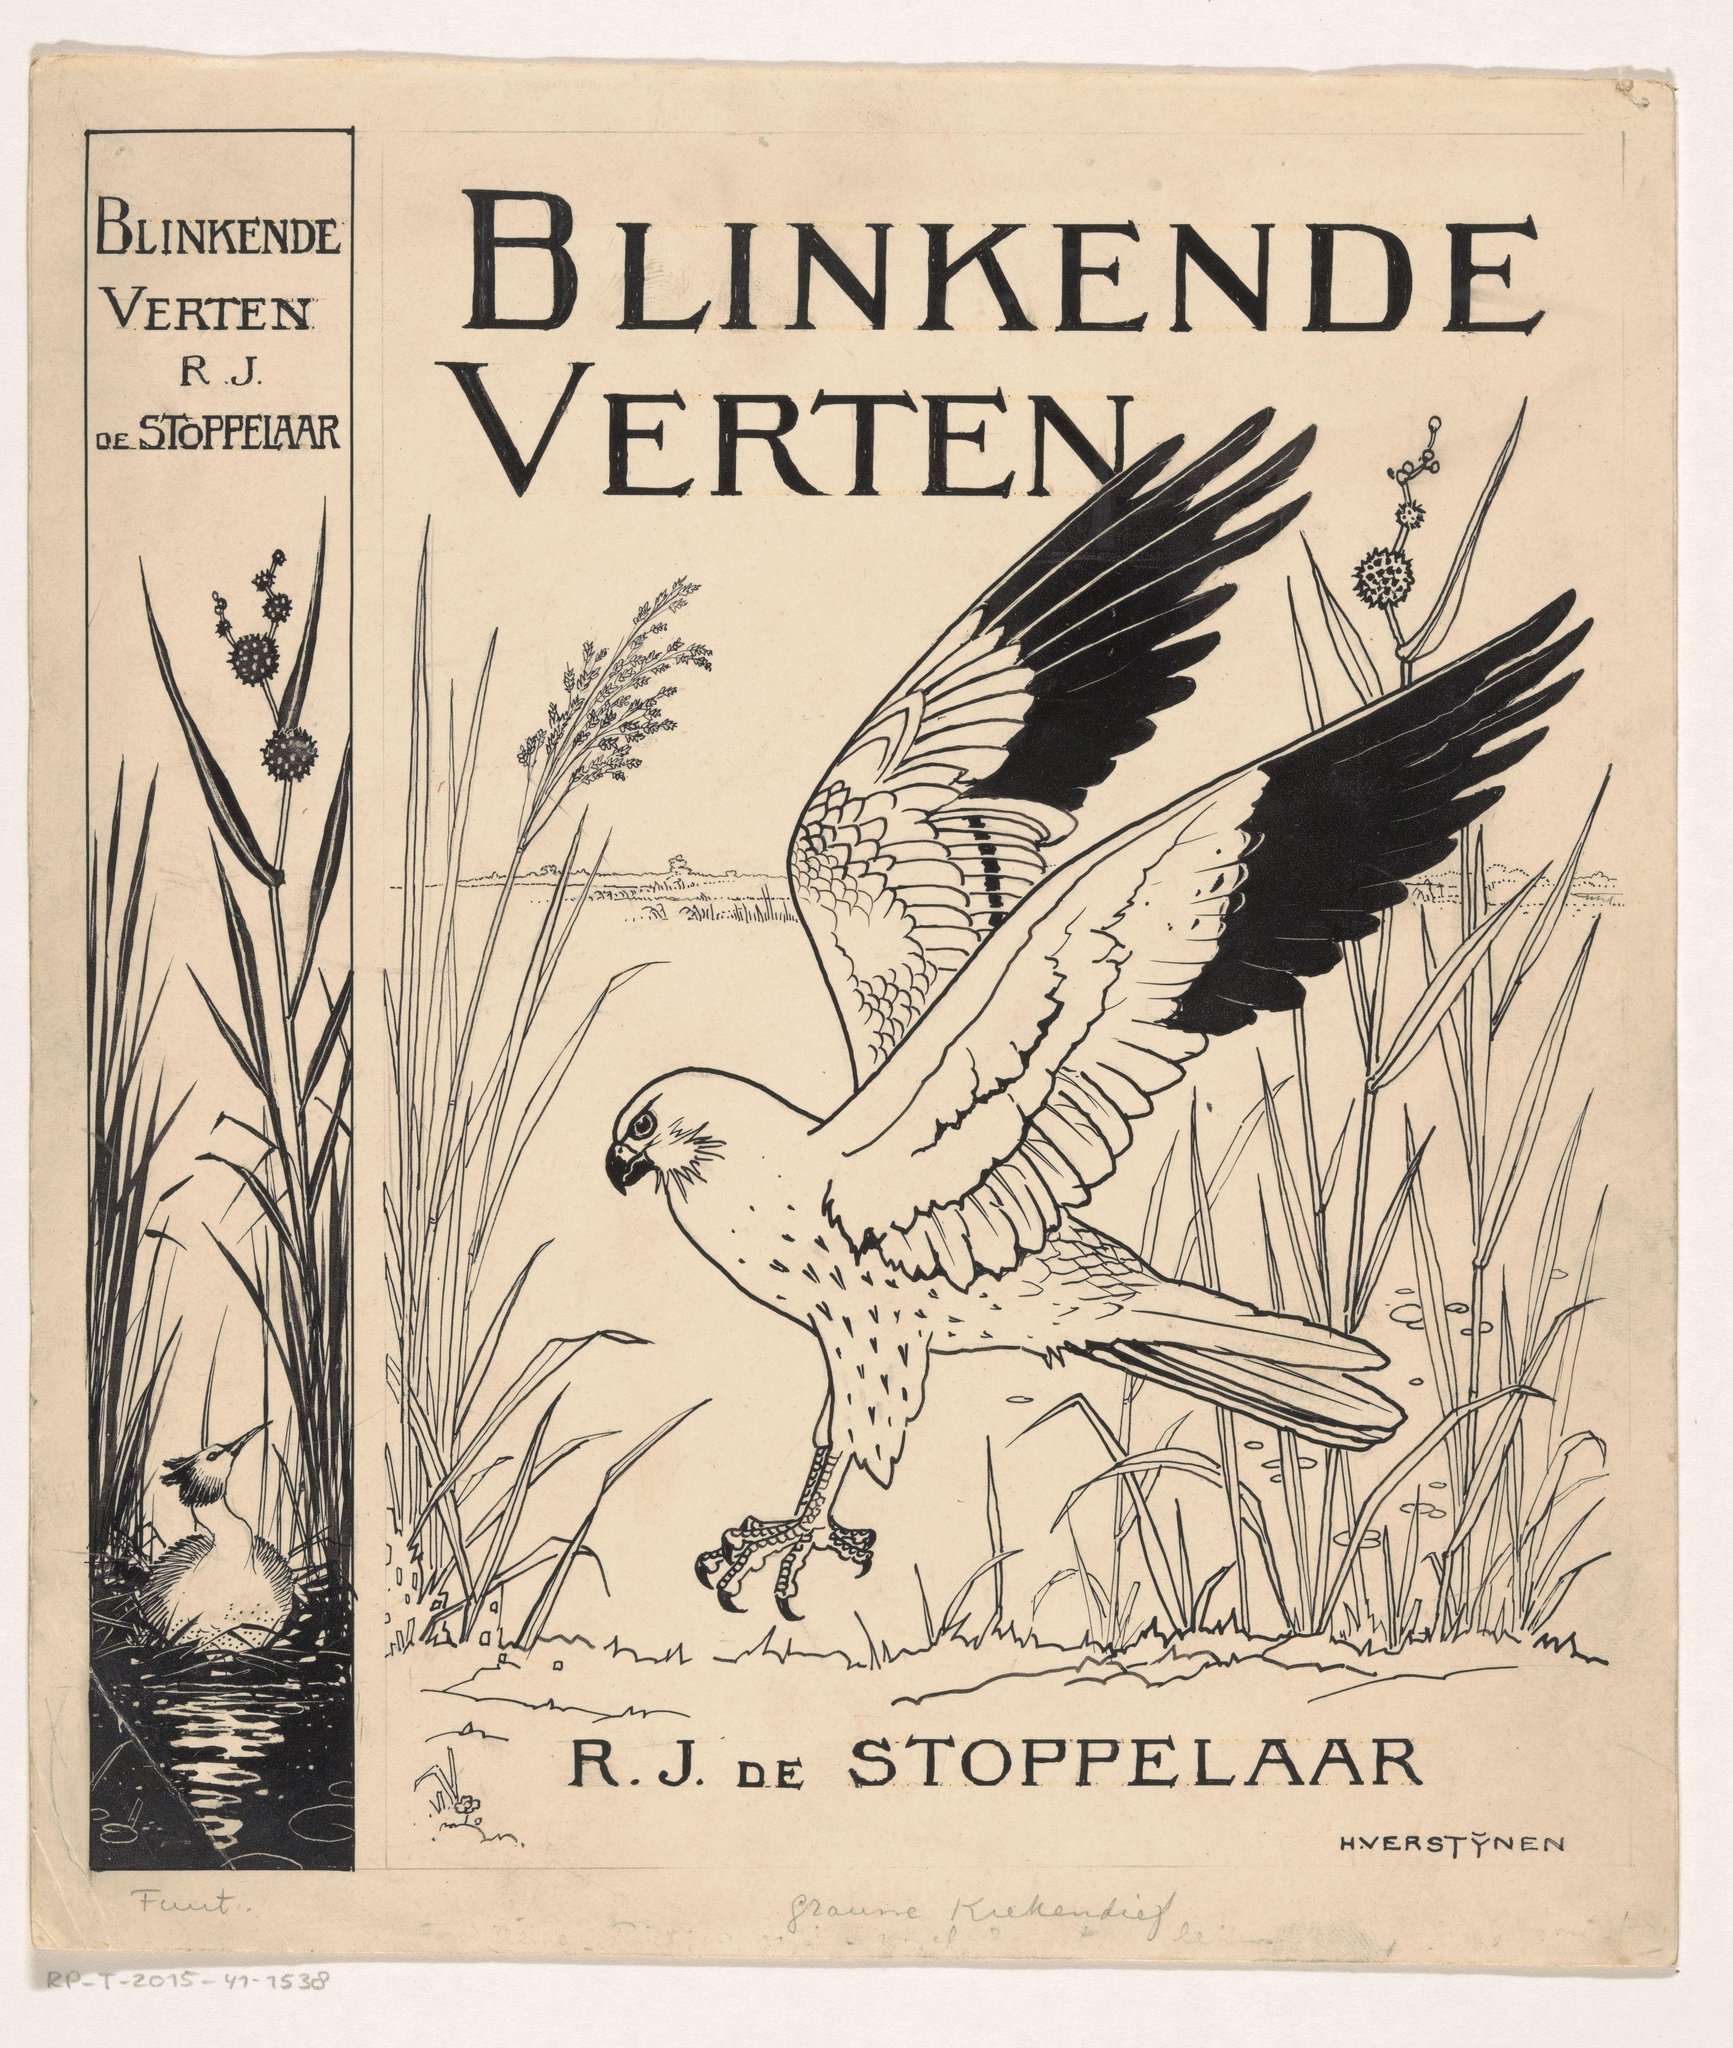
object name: drawing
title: Bandontwerp voor: R.J. de Stoppelaar, Blinkende verten, 1930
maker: henri verstijnen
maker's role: draughtsman, print maker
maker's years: 1882-1940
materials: cardboard, ink, paper, pencil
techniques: brush, pen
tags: birds, landscapes with waters, waterscapes, seascapes (in the temperate zone)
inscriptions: :, collector's mark: Lugt 2228, signature: ‘H. VERSTYNEN’, annotation: ‘Fuut. Grauwe Kiekendief’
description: Een grauwe kiekendief landt aan een waterkant tussen het riet. Op de boekrug een fuut op een nest tussen de rietstengels.